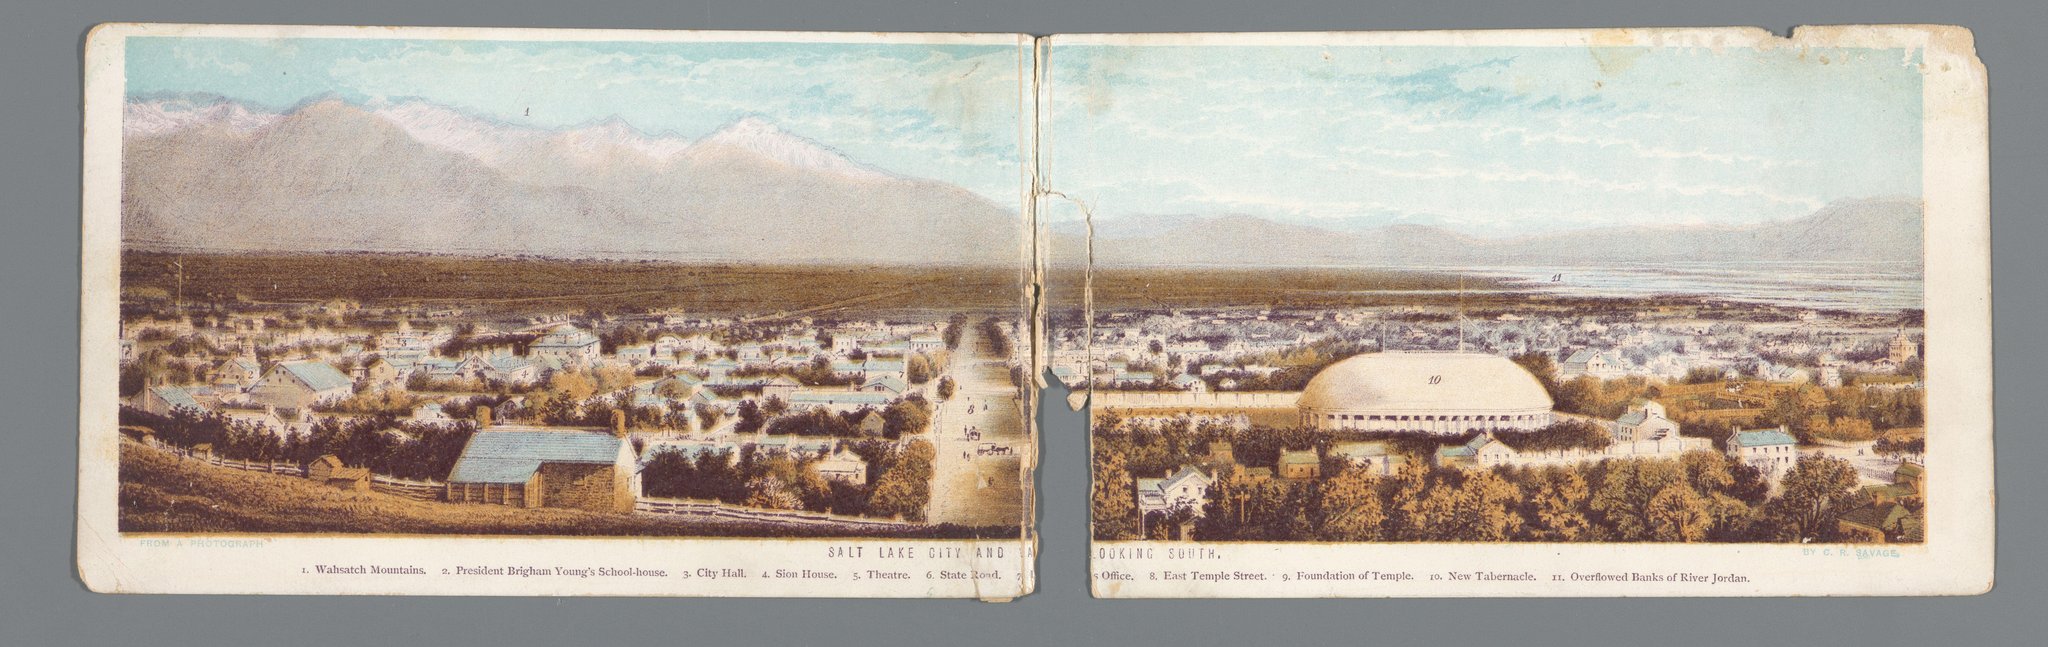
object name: print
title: Great Salt Lake City and views in Utah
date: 1870-1875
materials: paper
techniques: lithograph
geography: new york city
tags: city-view in general; 'veduta'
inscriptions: inscription: ‘From a photograph by C.R. Savage.’, inscription: ‘1. Wahsatch Mountains (...) River Jordan’